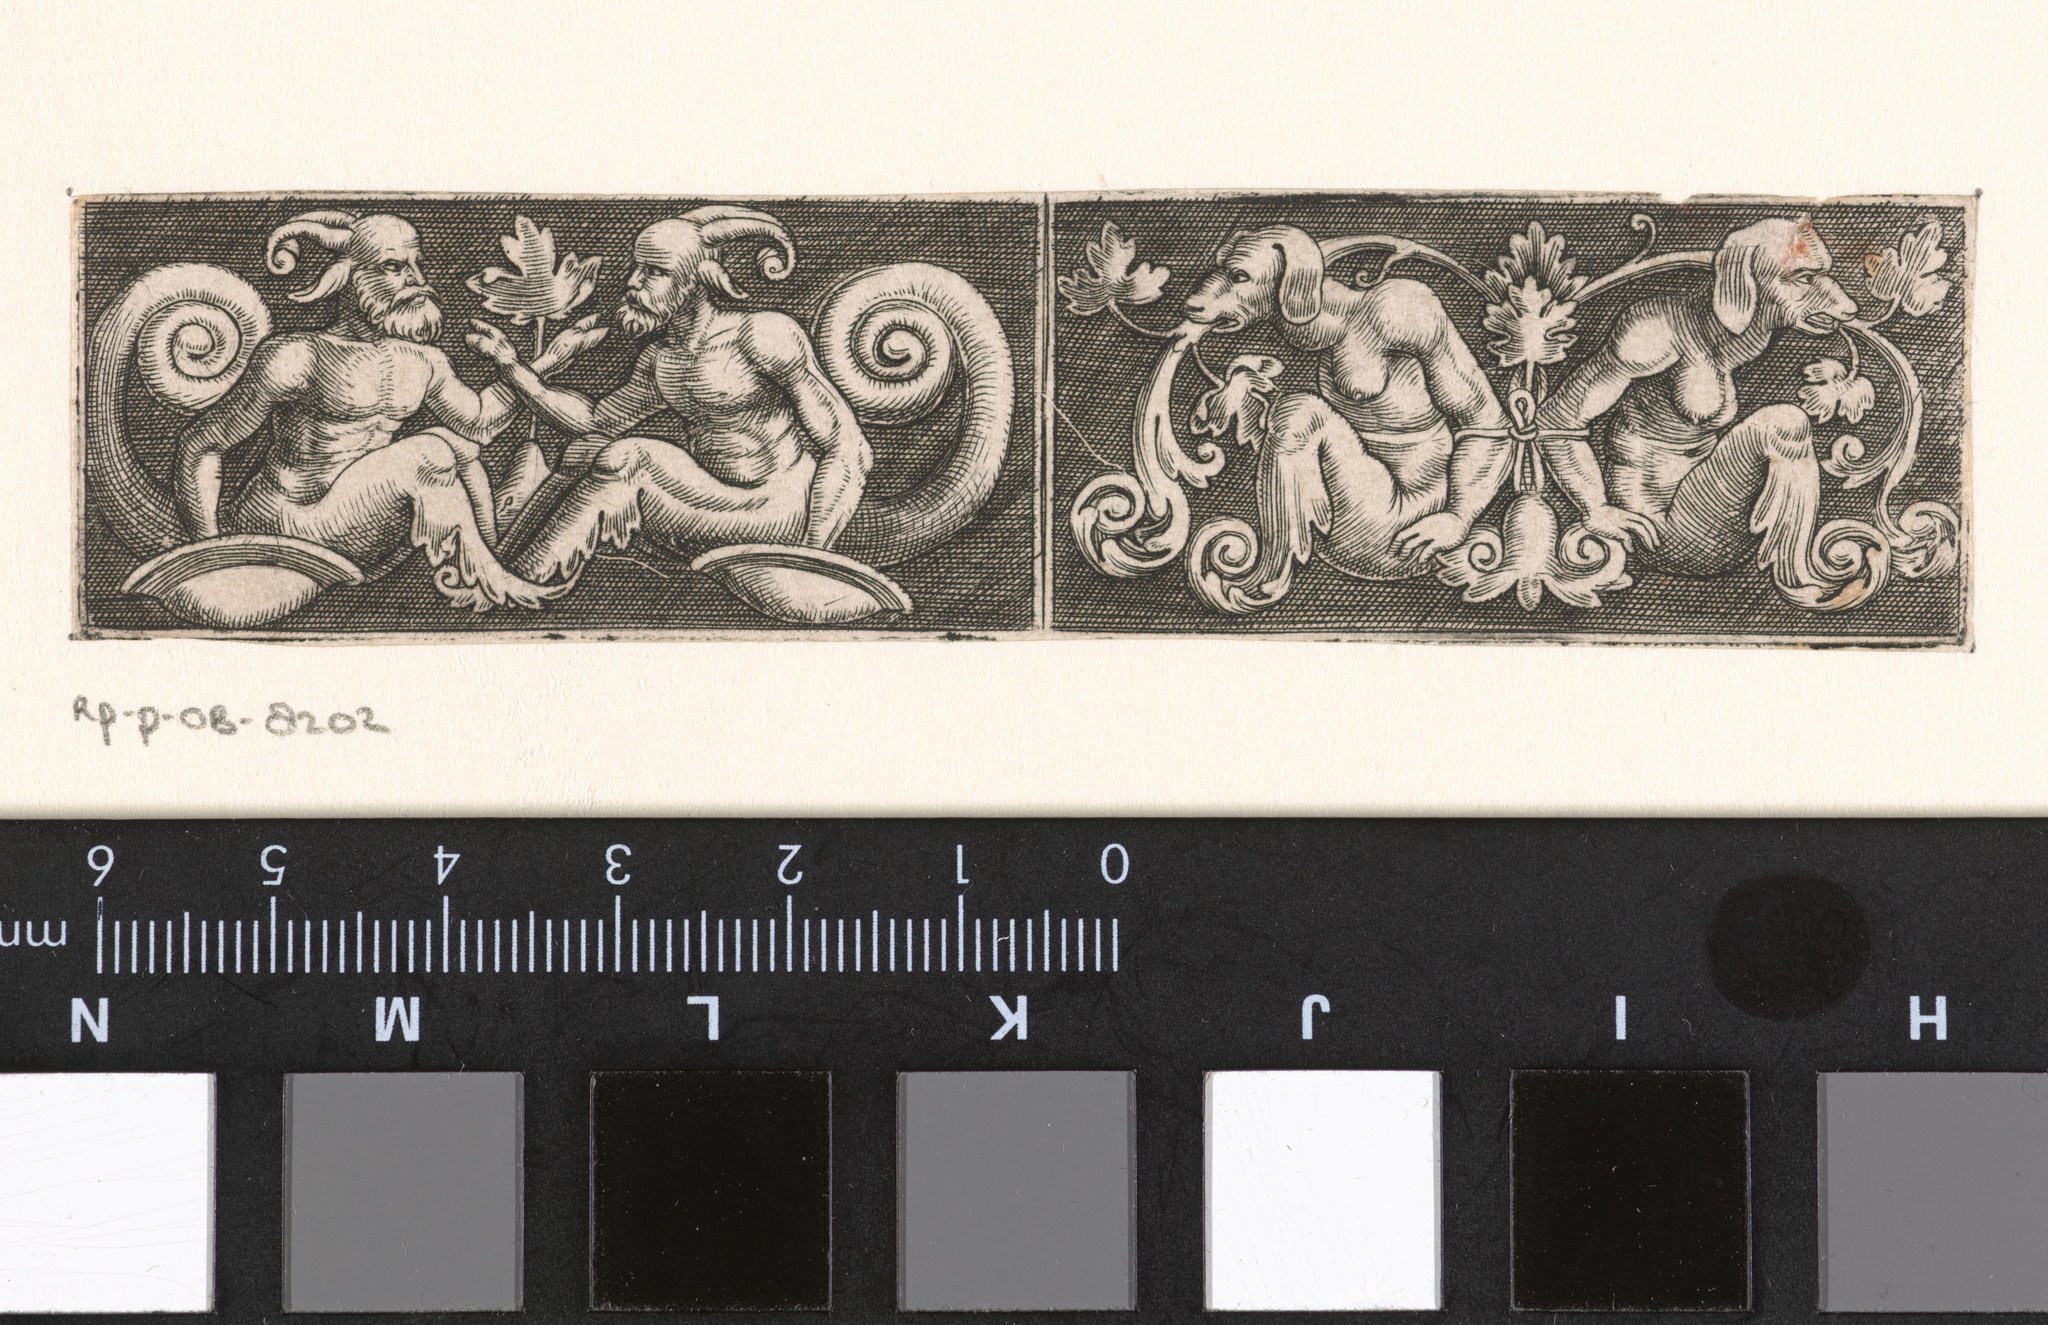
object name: print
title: Fries met links twee saters tegenover elkaar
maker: Anonymous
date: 1500-1600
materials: paper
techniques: engraving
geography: germany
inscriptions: collector's mark: Lugt 240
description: De saters zitten op hun schild. Rechts zitten twee vrouwelijke figuren met hondenkoppen rug aan rug vastgebonden. Gearceerde achtergrond.